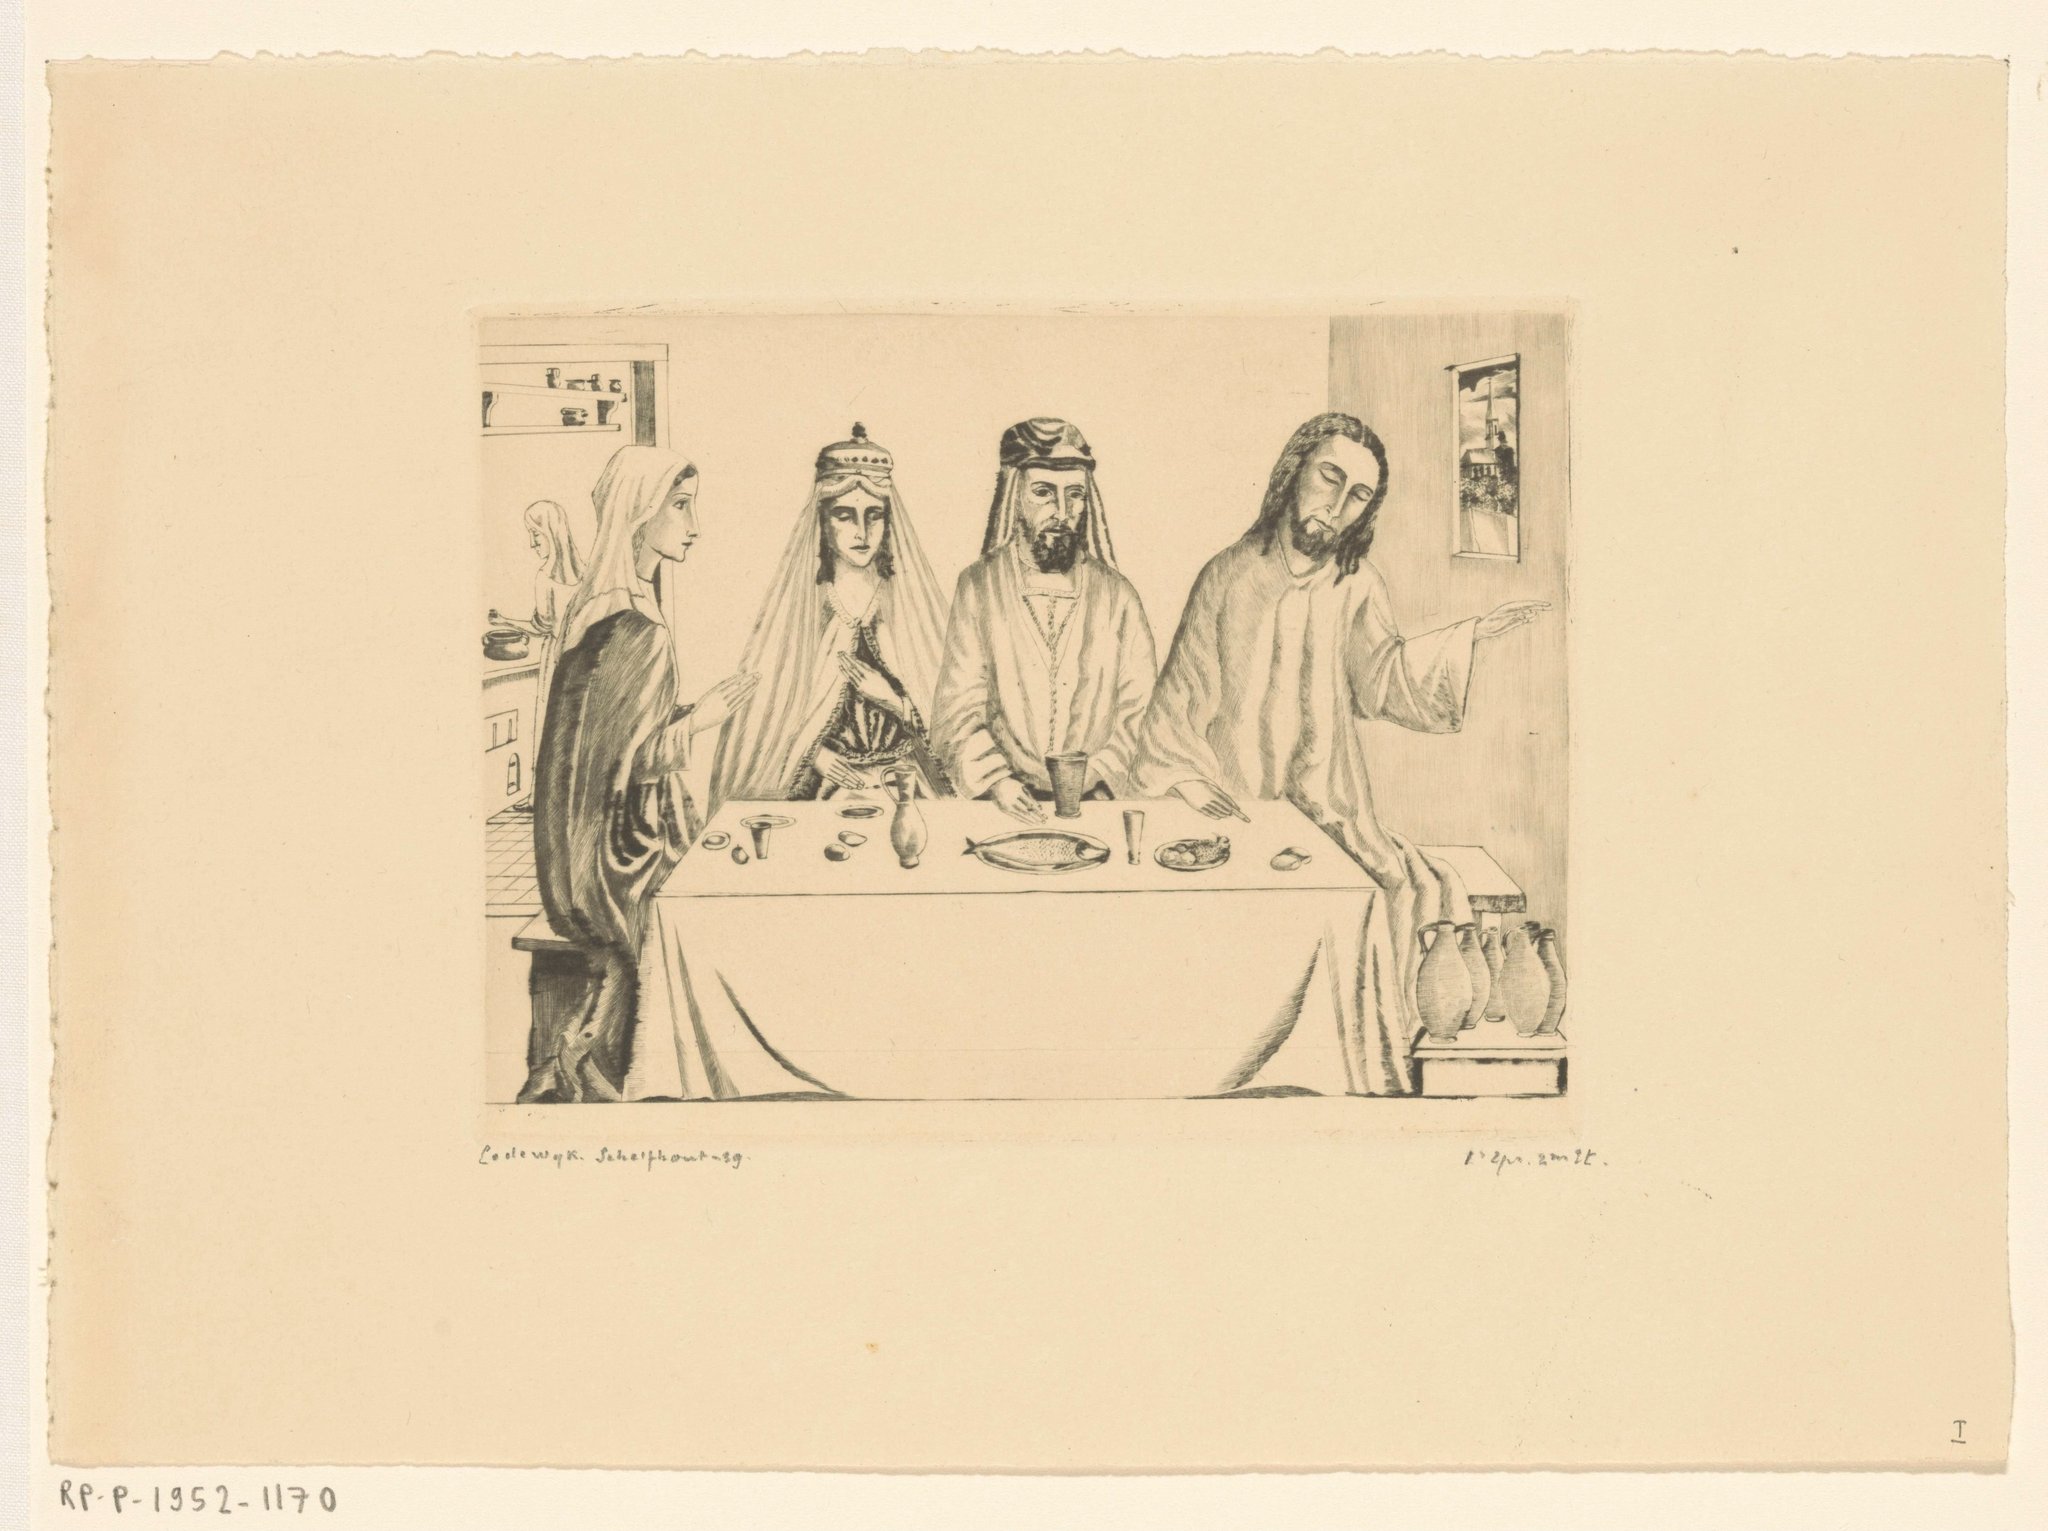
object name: print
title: Le Miracle de Cana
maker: lodewijk schelfhout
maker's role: draughtsman, print maker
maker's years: 1881-1943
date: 1939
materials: paper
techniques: drypoint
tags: the marriage-feast at cana (john 2:1-11)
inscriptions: collector's mark: Lugt 2228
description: Maria, een bruid en bruidegom, en Christus, gezeten aan een tafel. Christus zegent zes stenen wijnvaten, waardoor de inhoud ervan veranderd van water in wijn. Bij deze tweede staat van de prent zijn er op de achtergrond een vrouw in een keuken en een raam dat uitzicht biedt op een kerk toegevoegd.